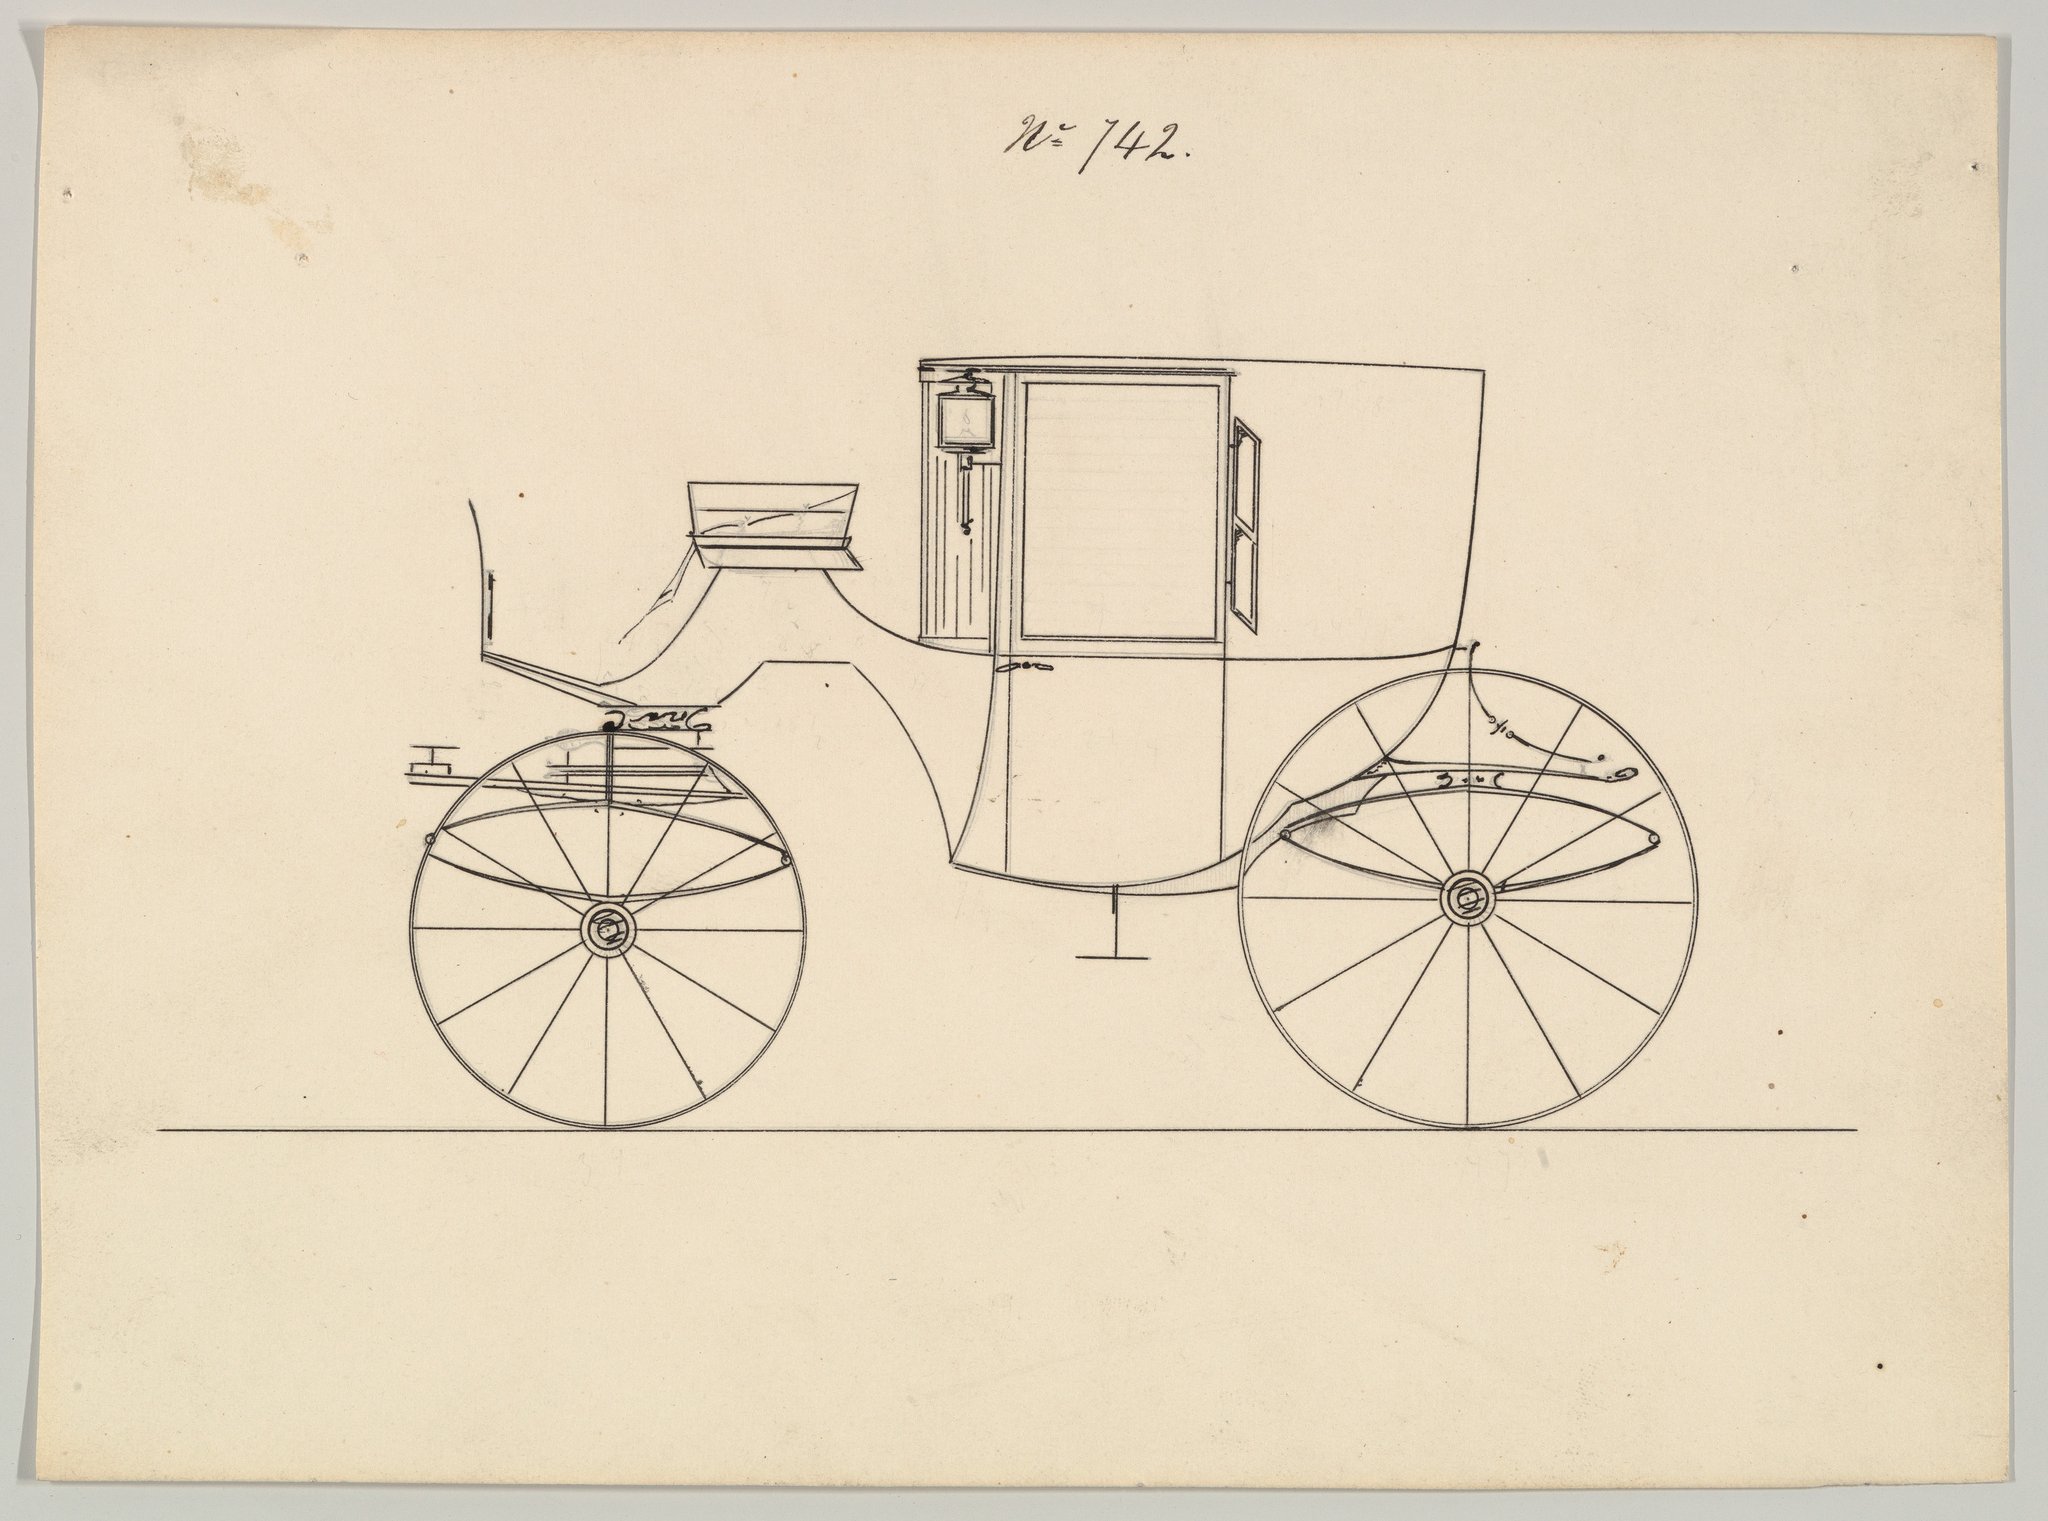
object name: drawing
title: Coupé # 742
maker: brewster & co.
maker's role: manufacturer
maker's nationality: american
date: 1850-1870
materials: ink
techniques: pen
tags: carriages